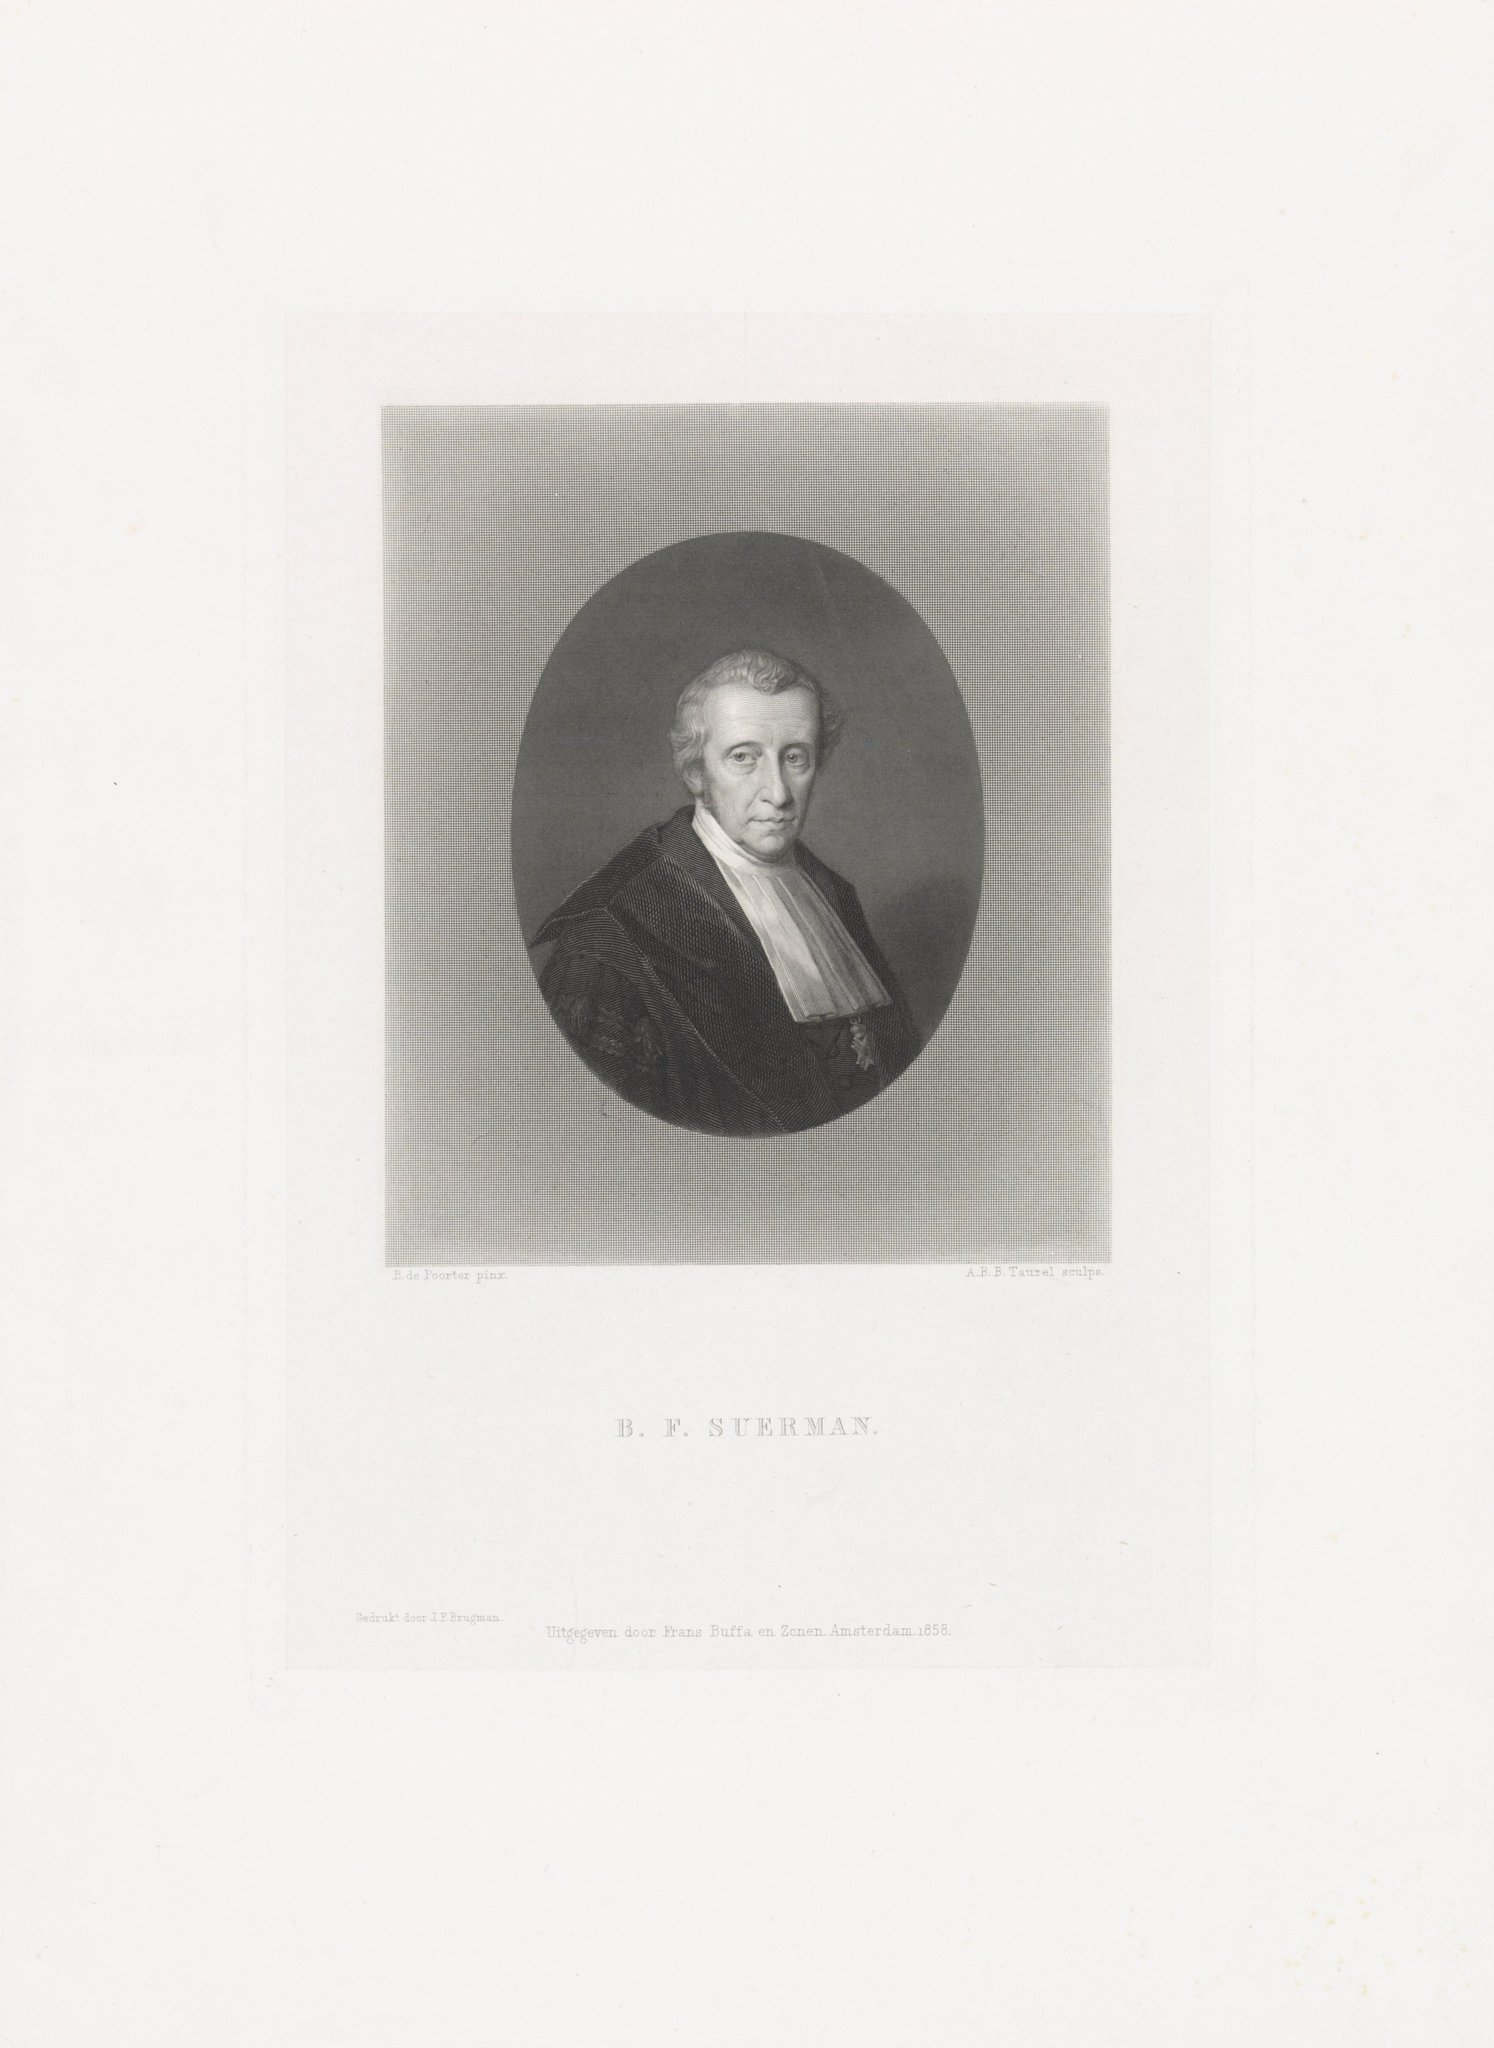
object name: print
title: Portret van de onderwijzer Bernardus Franciscus Suerman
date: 1858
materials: paper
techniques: engraving, etching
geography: amsterdam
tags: haarlem, utrecht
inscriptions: collector's mark: Lugt 2228